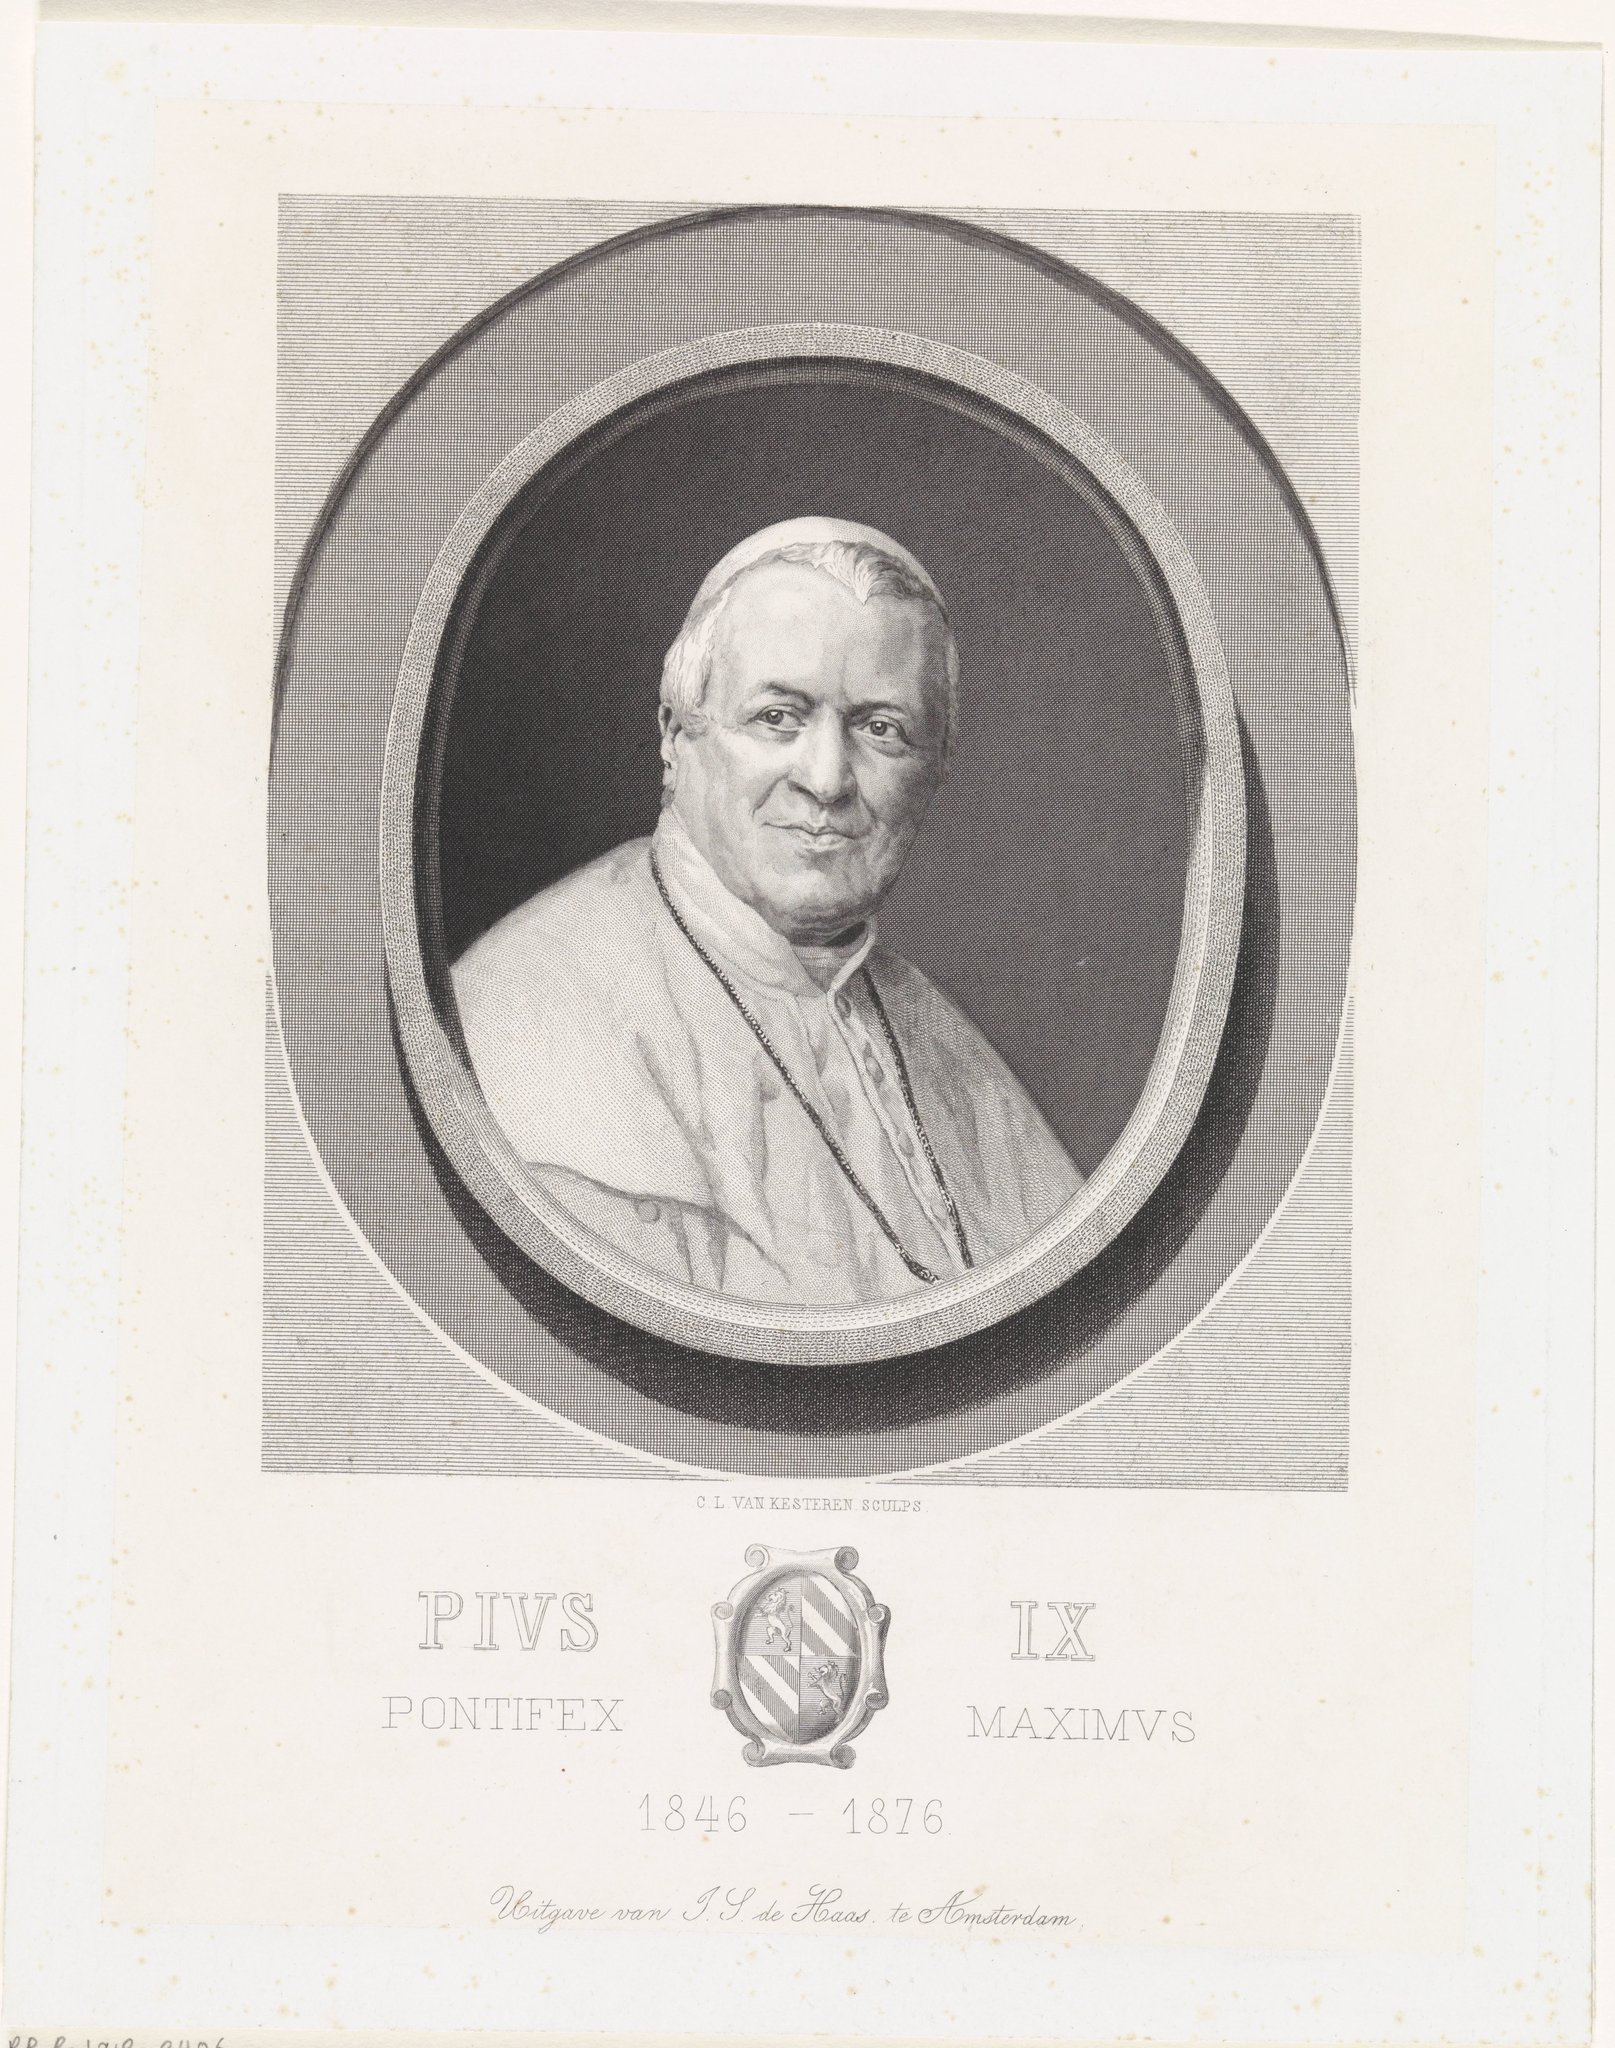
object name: print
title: Pius IX Pontifex Maximus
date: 1876-1881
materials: paper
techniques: engraving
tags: rome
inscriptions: collector's mark: Lugt 2228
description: Portretbuste van Paus Pius IX, gehuld in pauselijke kleding, ter gelegenheid van zijn dertigjarig jubileum als paus.